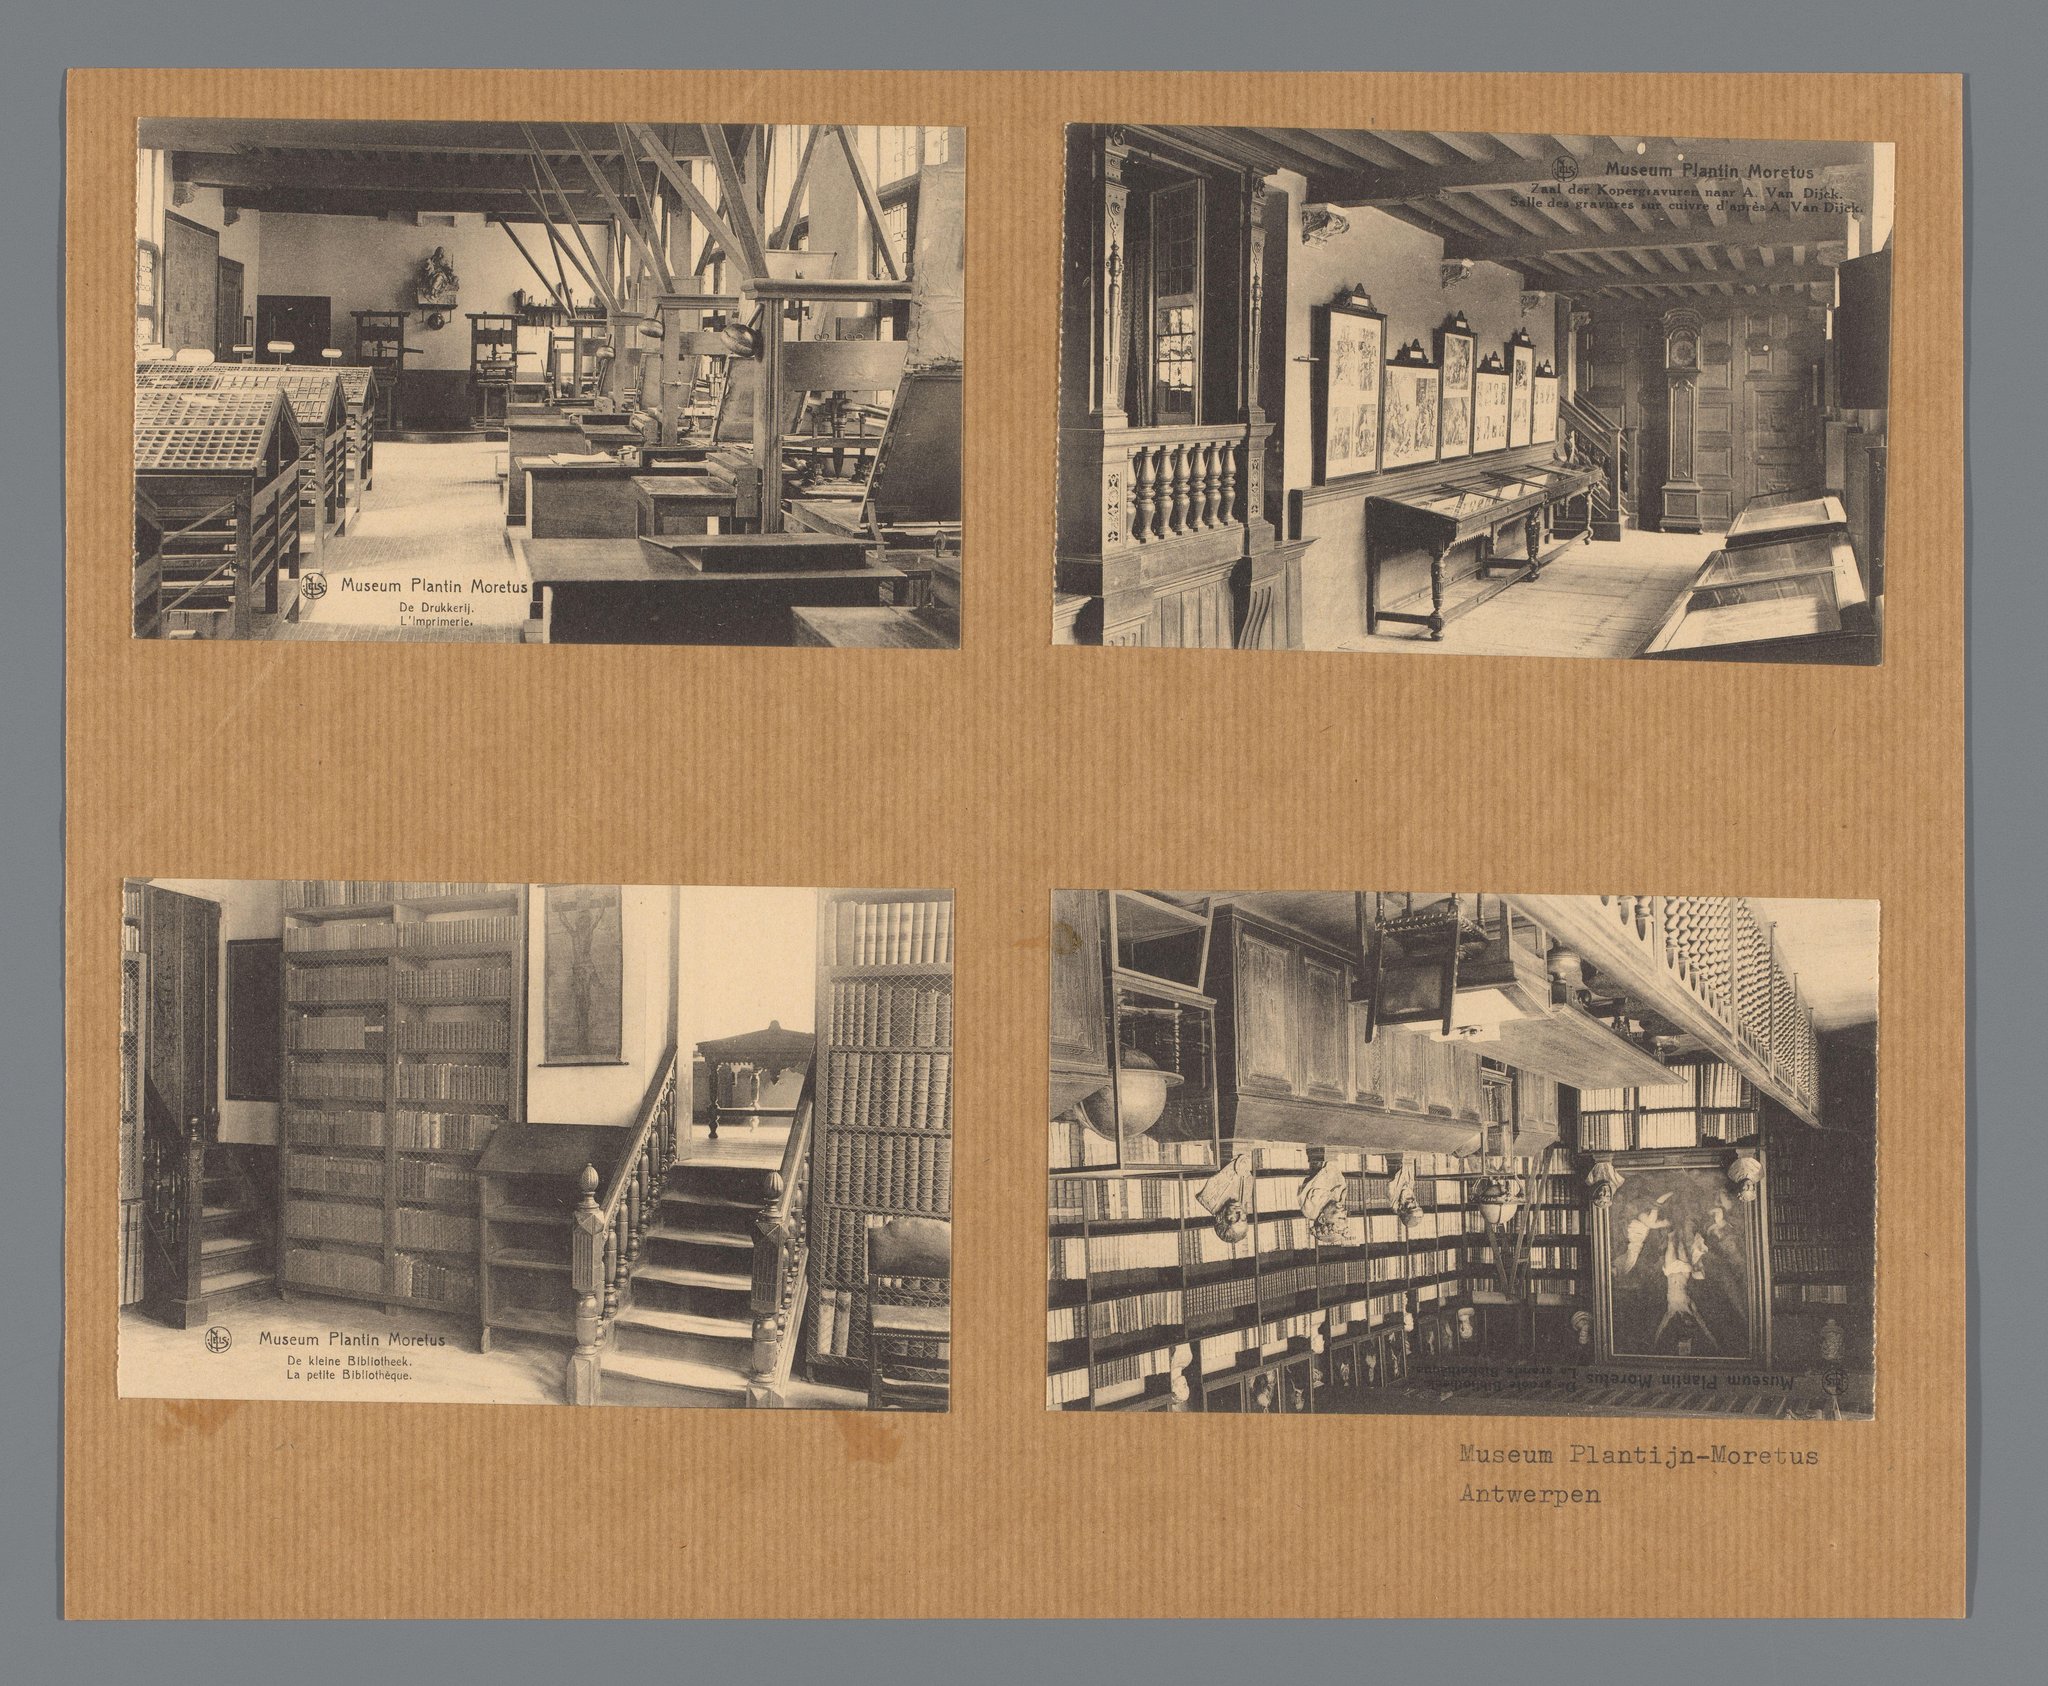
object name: photograph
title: Antwerpen. Museum Plantijn - Moretus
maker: Anonymous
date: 1860-1925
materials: photographic support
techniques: photograph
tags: museum plantin-moretus